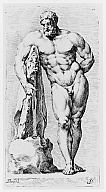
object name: print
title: Hercules after the antique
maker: jan de bisschop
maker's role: artist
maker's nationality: dutch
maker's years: 1628-1671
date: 1601-1700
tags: hercules